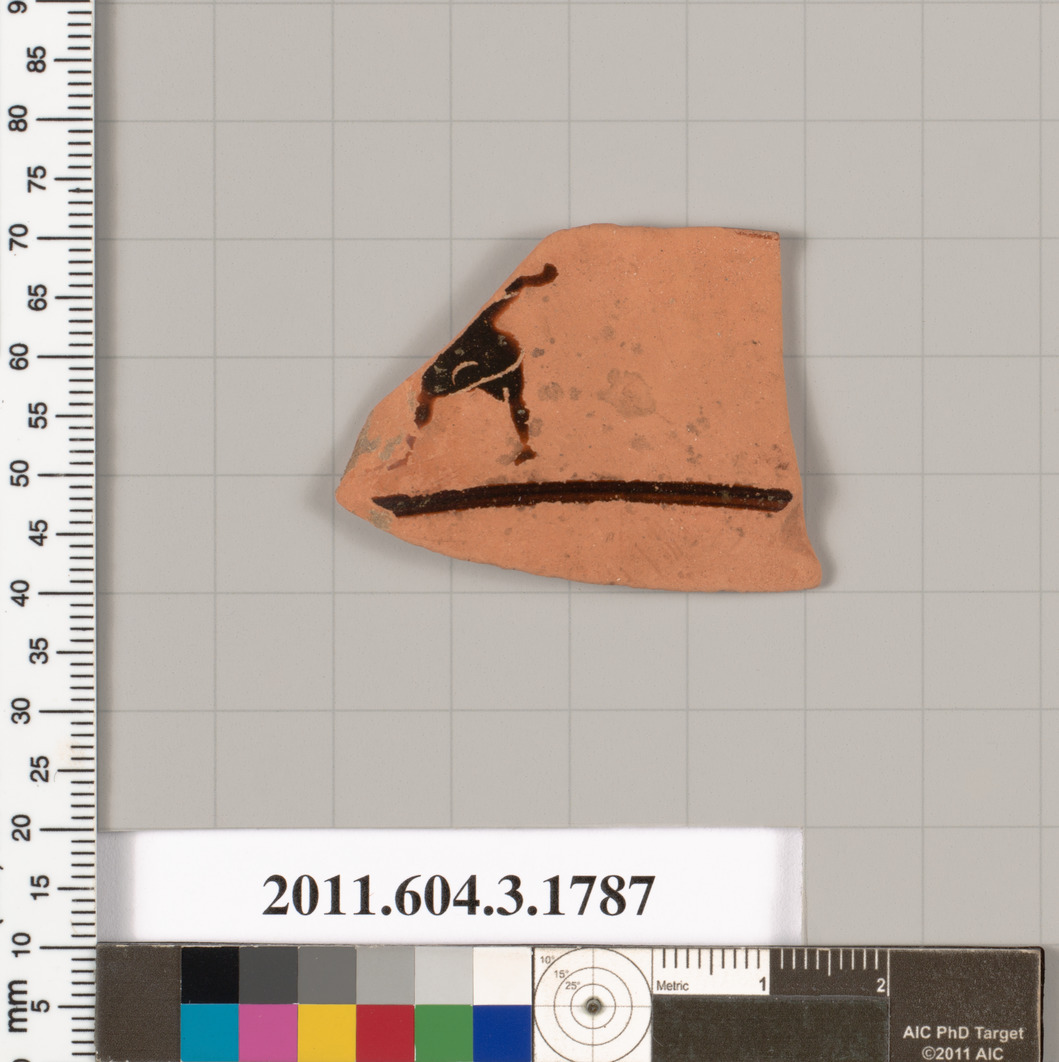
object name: kylix fragment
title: Terracotta rim fragment of a kylix: Lip cup (drinking cup)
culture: greek, attic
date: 550-526 BCE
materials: terracotta